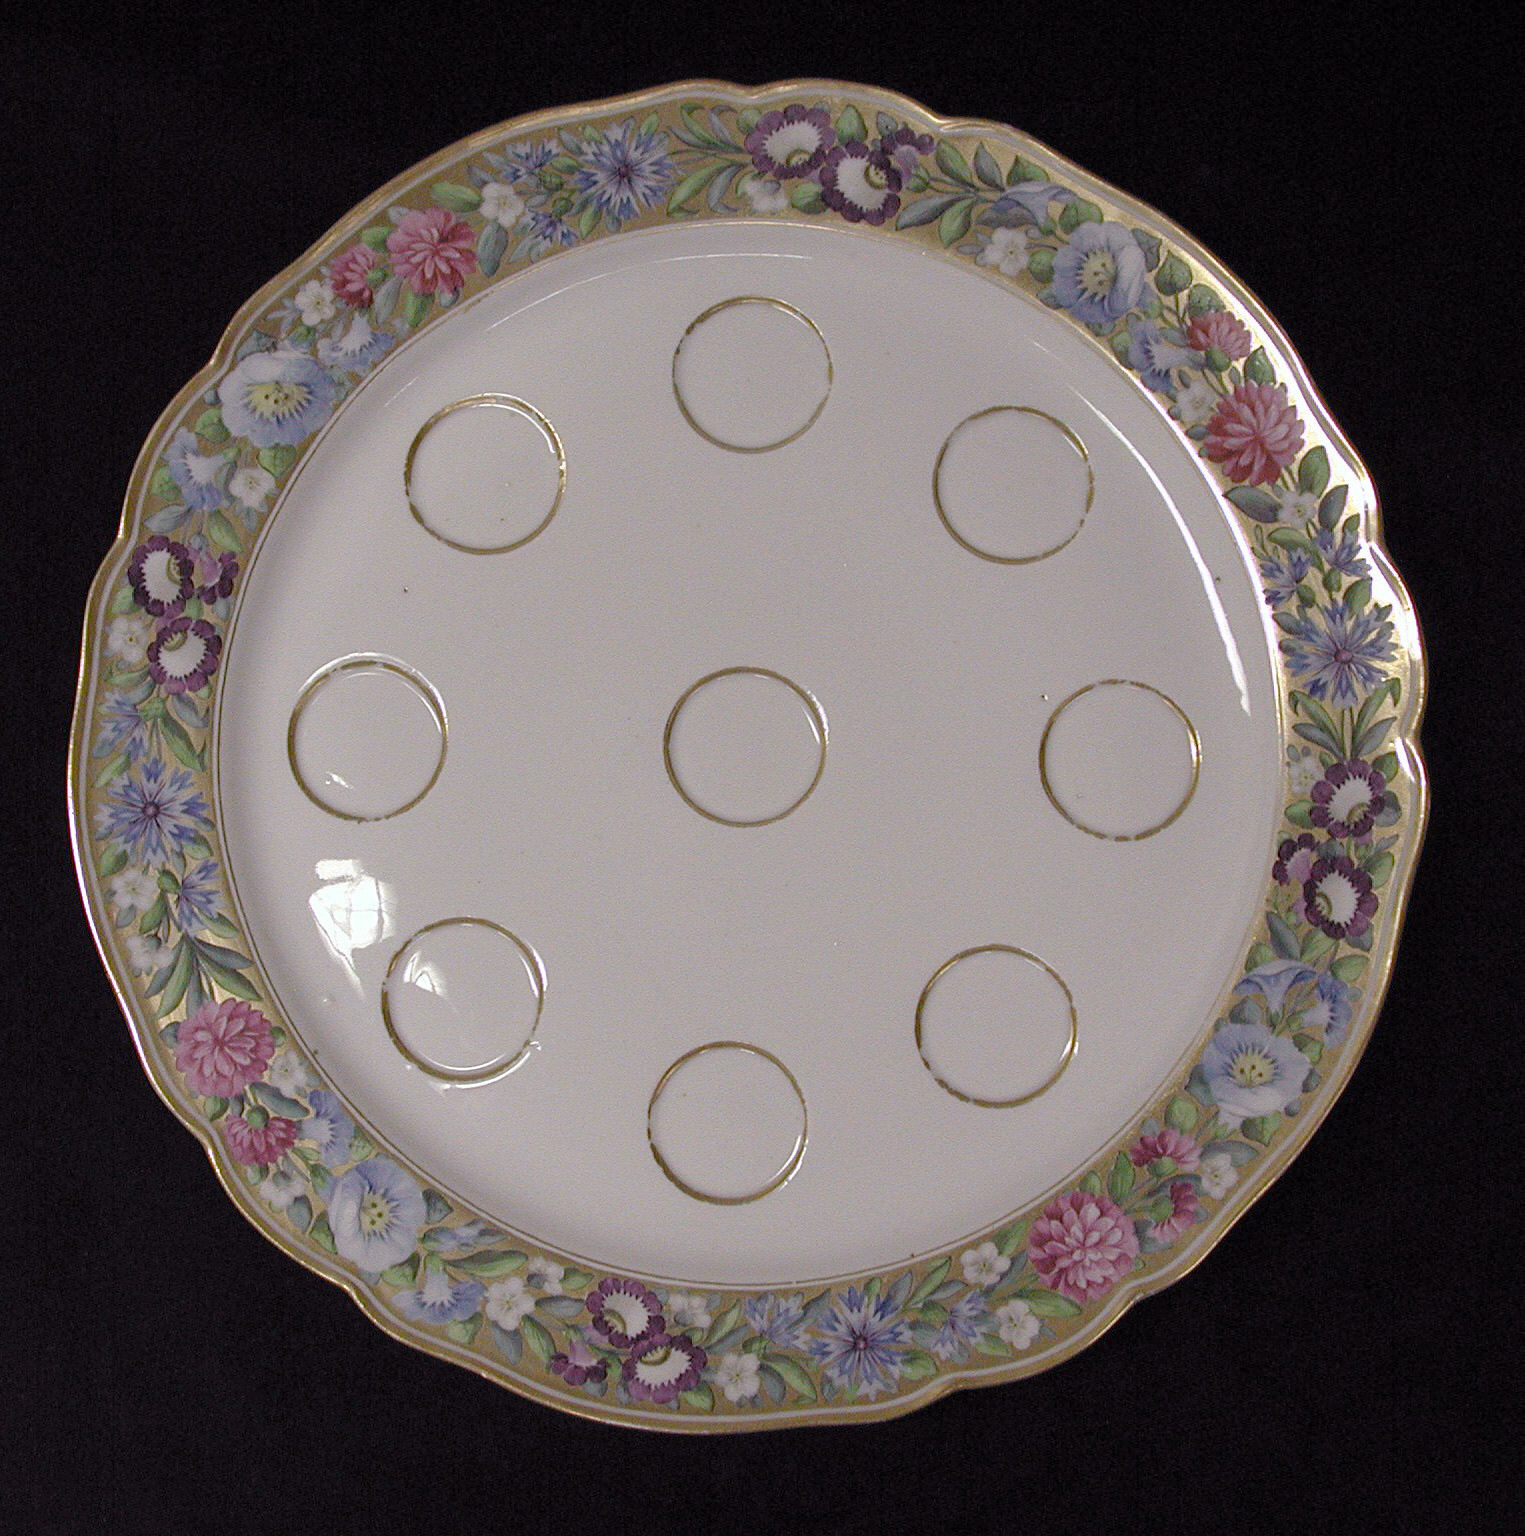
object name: tray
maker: imperial porcelain manufactory, st. petersburg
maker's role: manufactory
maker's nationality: russian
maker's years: 1744-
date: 1801-1825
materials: hard paste porcelain